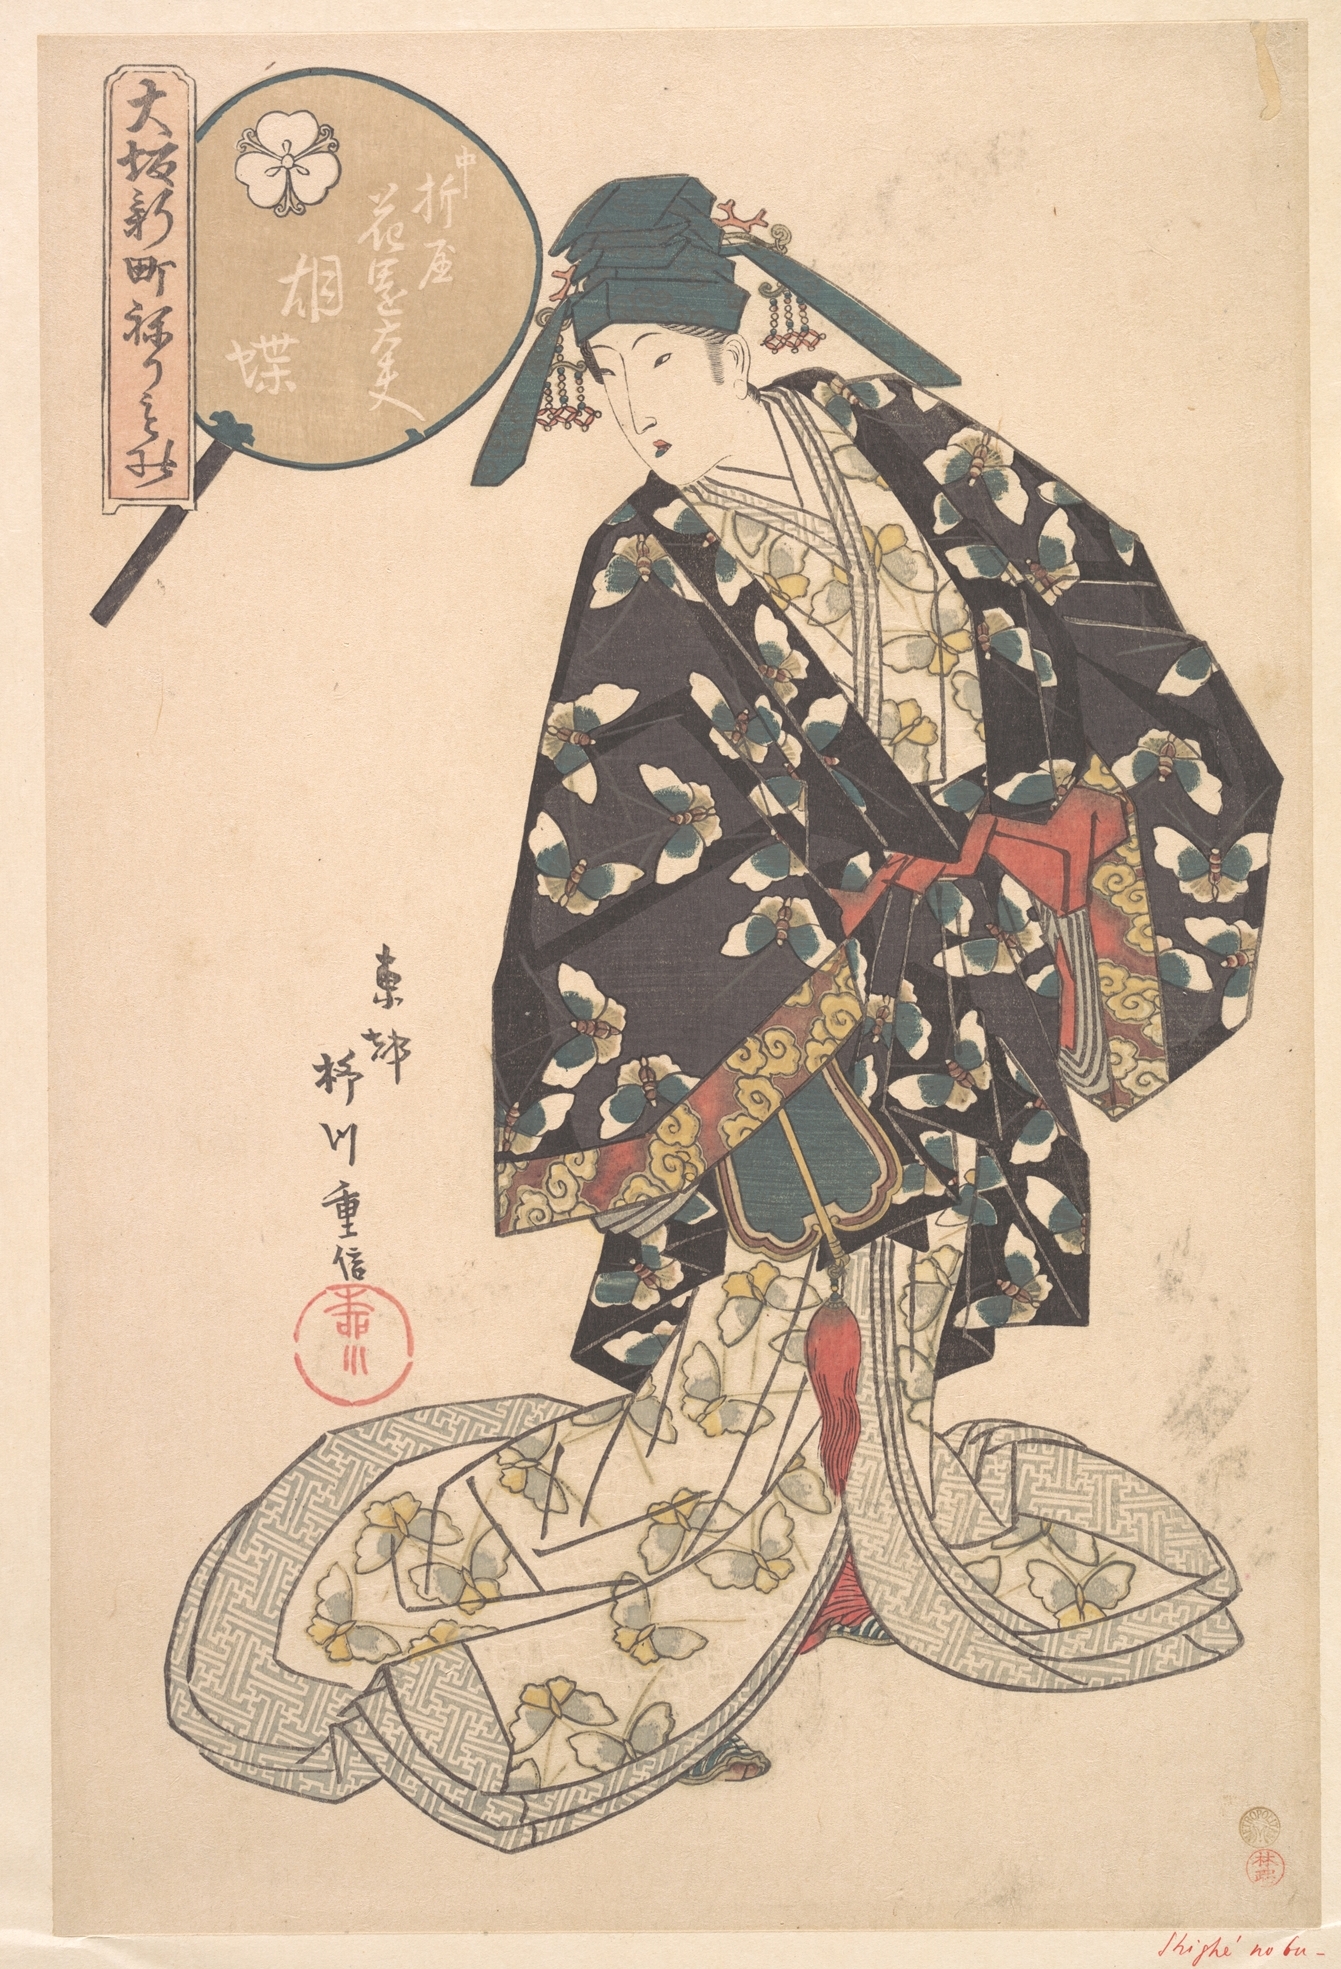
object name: print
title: Hanazono of Nakaori-ya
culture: japanese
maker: yanagawa shigenobu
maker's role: artist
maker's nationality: japanese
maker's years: 1787-1832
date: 1825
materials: ink, paper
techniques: woodblock print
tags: human figures